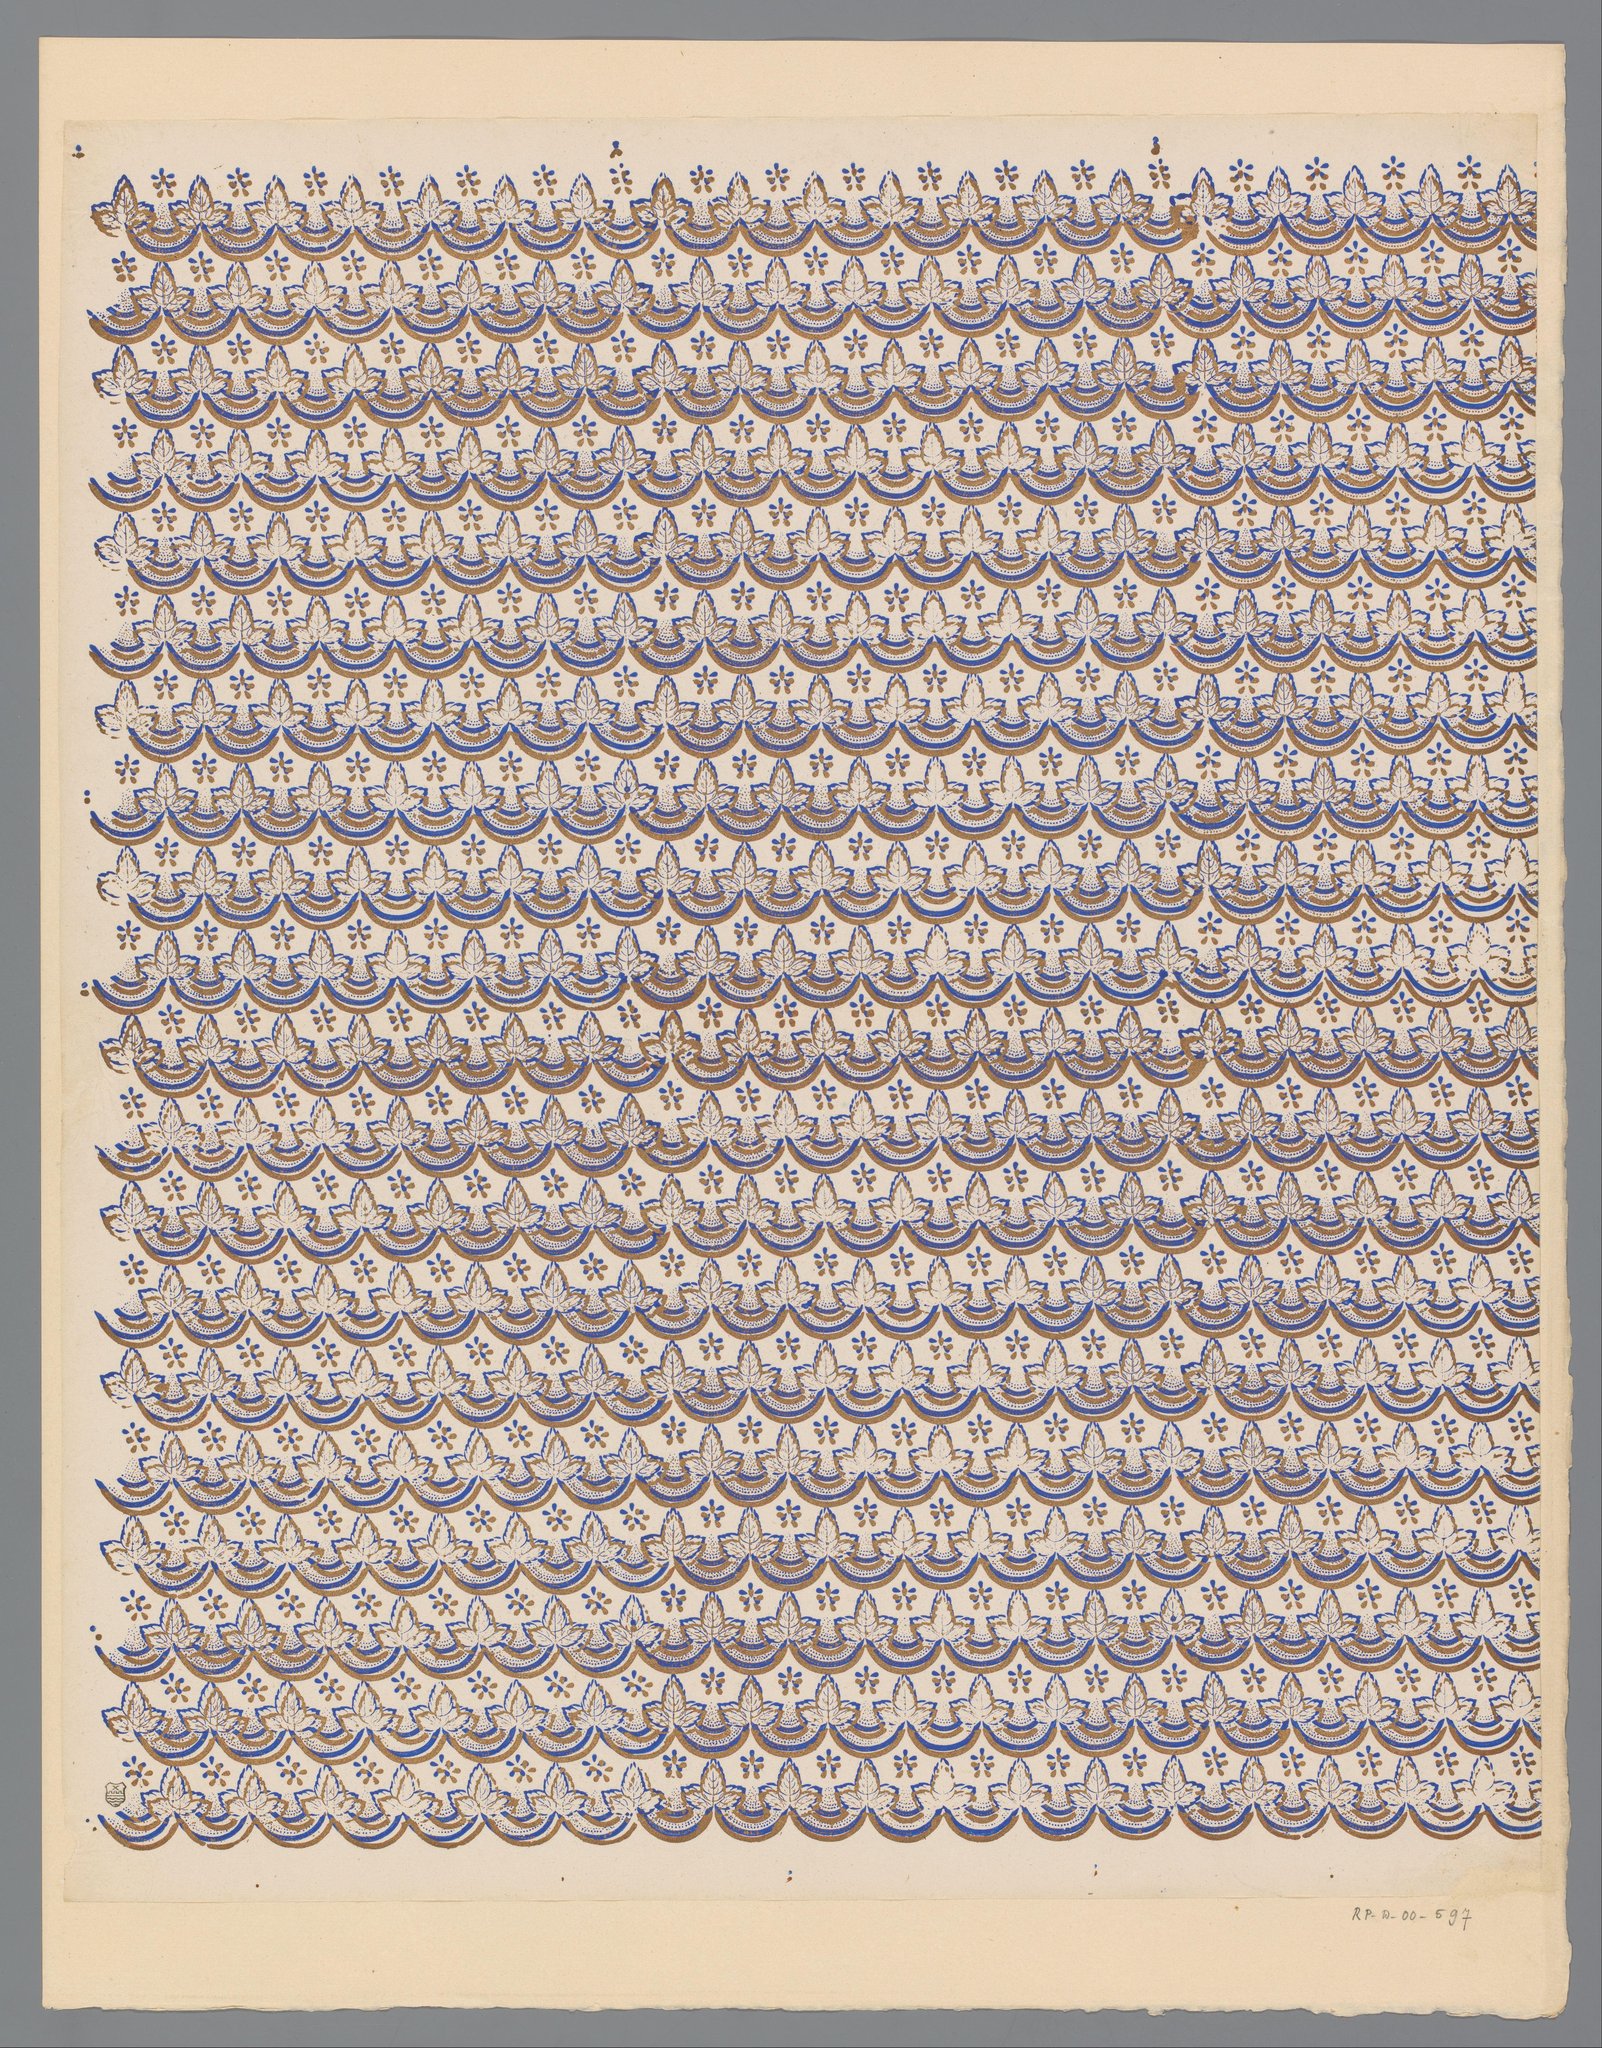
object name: printed paper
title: Blad met banenpatroon van bladmotief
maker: Anonymous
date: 1800-1900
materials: paint, paper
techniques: printing block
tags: ornament derived from plant forms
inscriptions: collector's mark: Lugt 2760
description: Blad met horizontaal banenpatroon van door slingers verbonden bladeren.